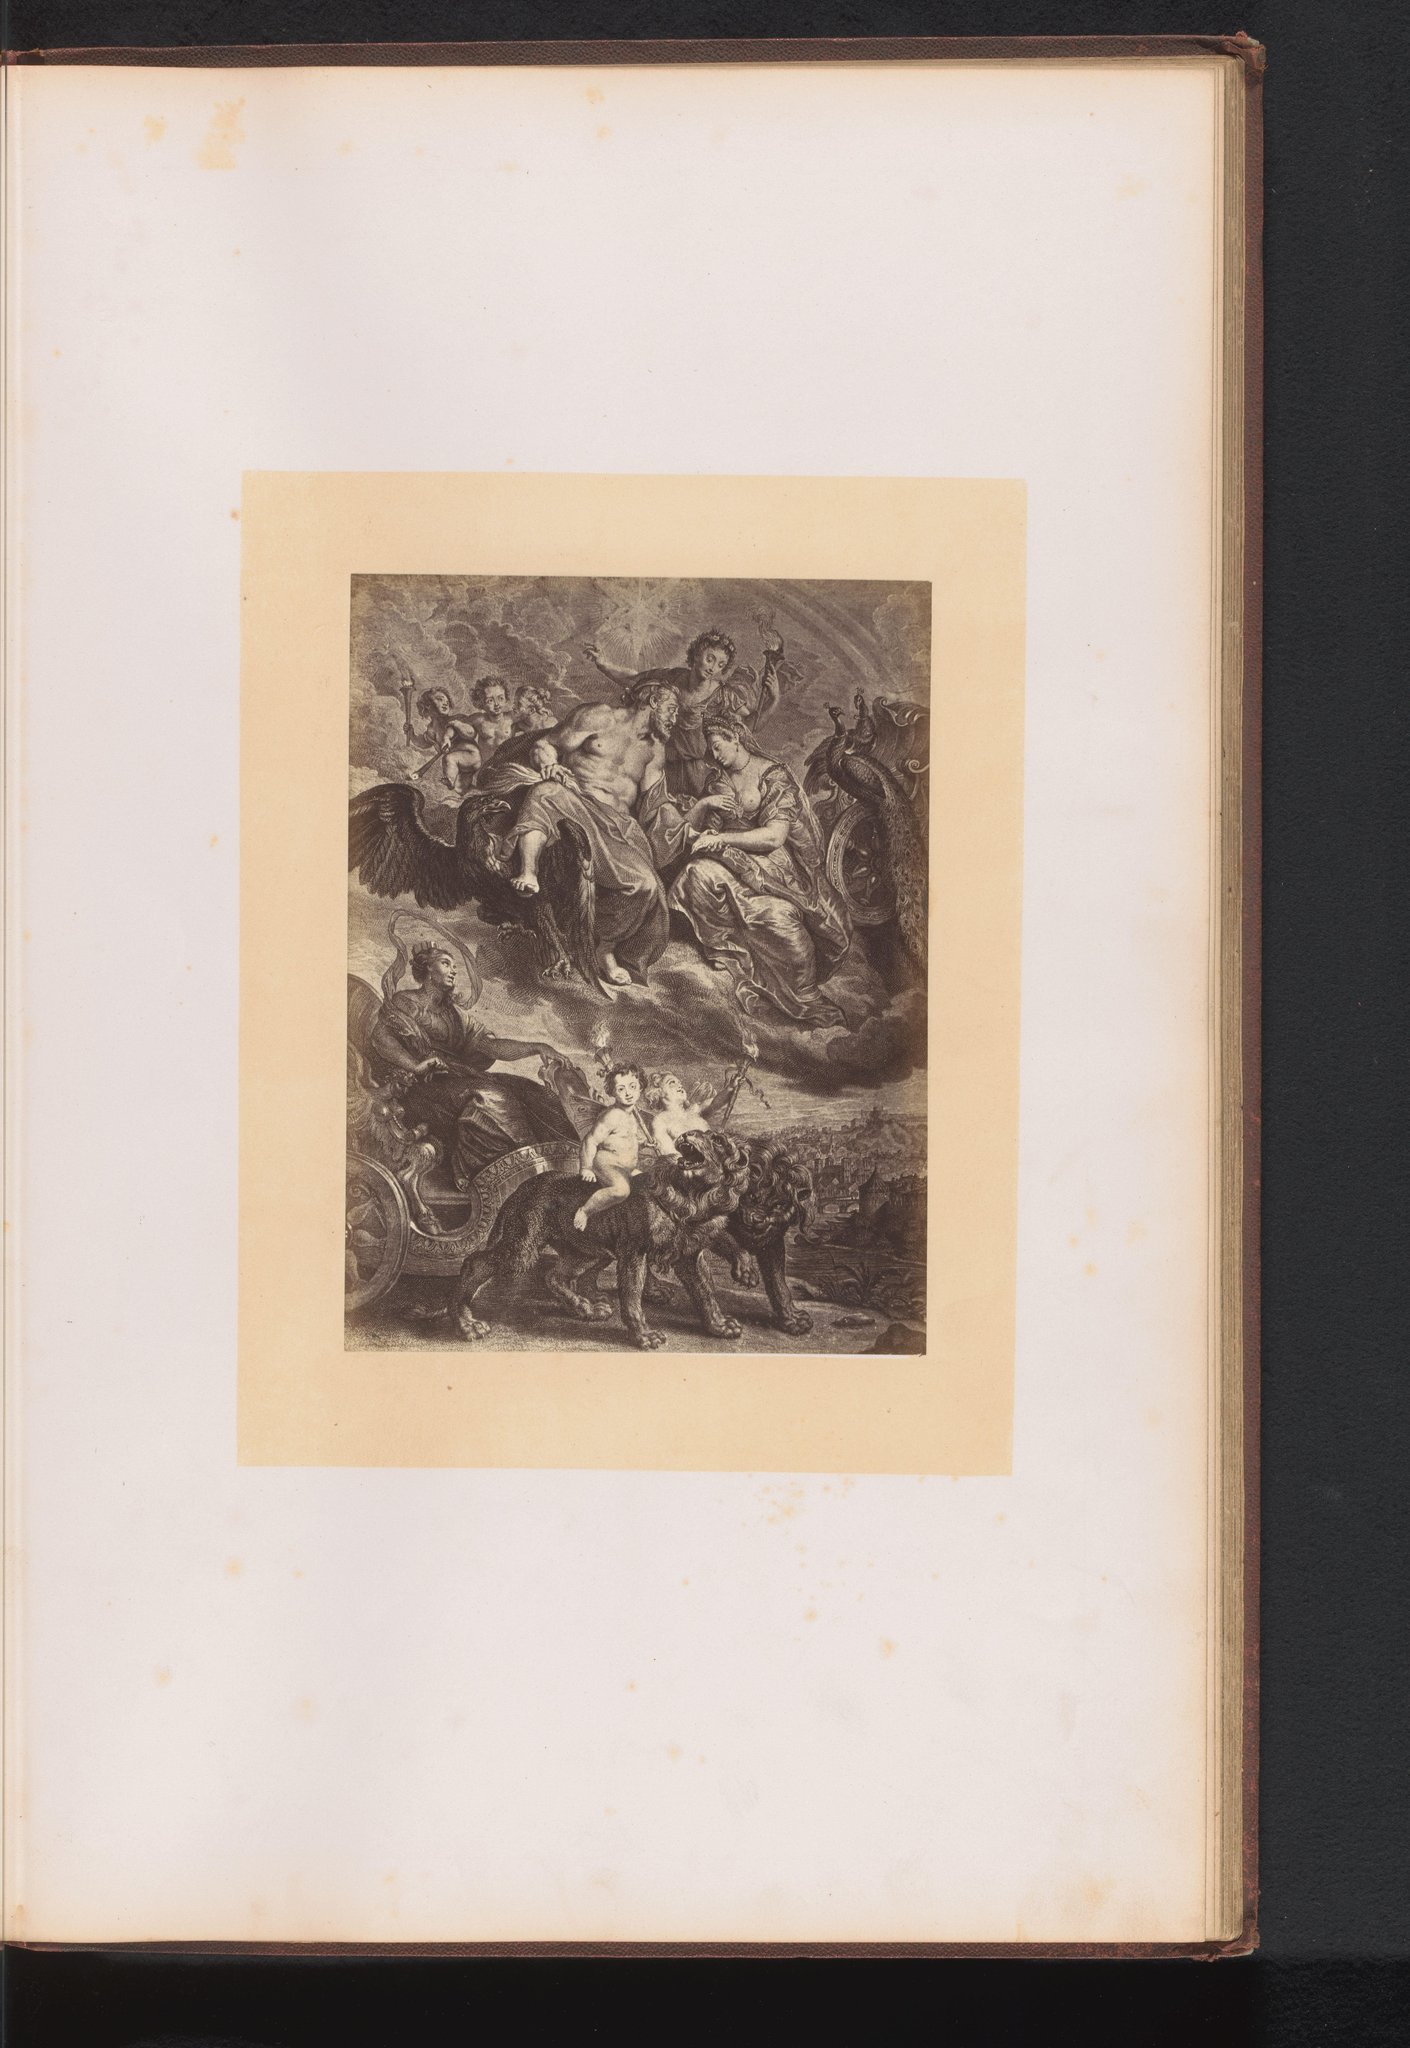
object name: page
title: Fotoreproductie van een gravure van De ontmoeting van Maria de'Medici en Hendrik IV in Lyon door Jean-Marc Nattier, naar het schilderij door Peter Paul Rubens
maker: peter paul rubens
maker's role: draughtsman, painter, print maker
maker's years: 1577-1640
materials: photographic support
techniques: albumen print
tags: print maker, maria de' medici, hendrik iv (koning van frankrijk en navarra), queen, king, lyon